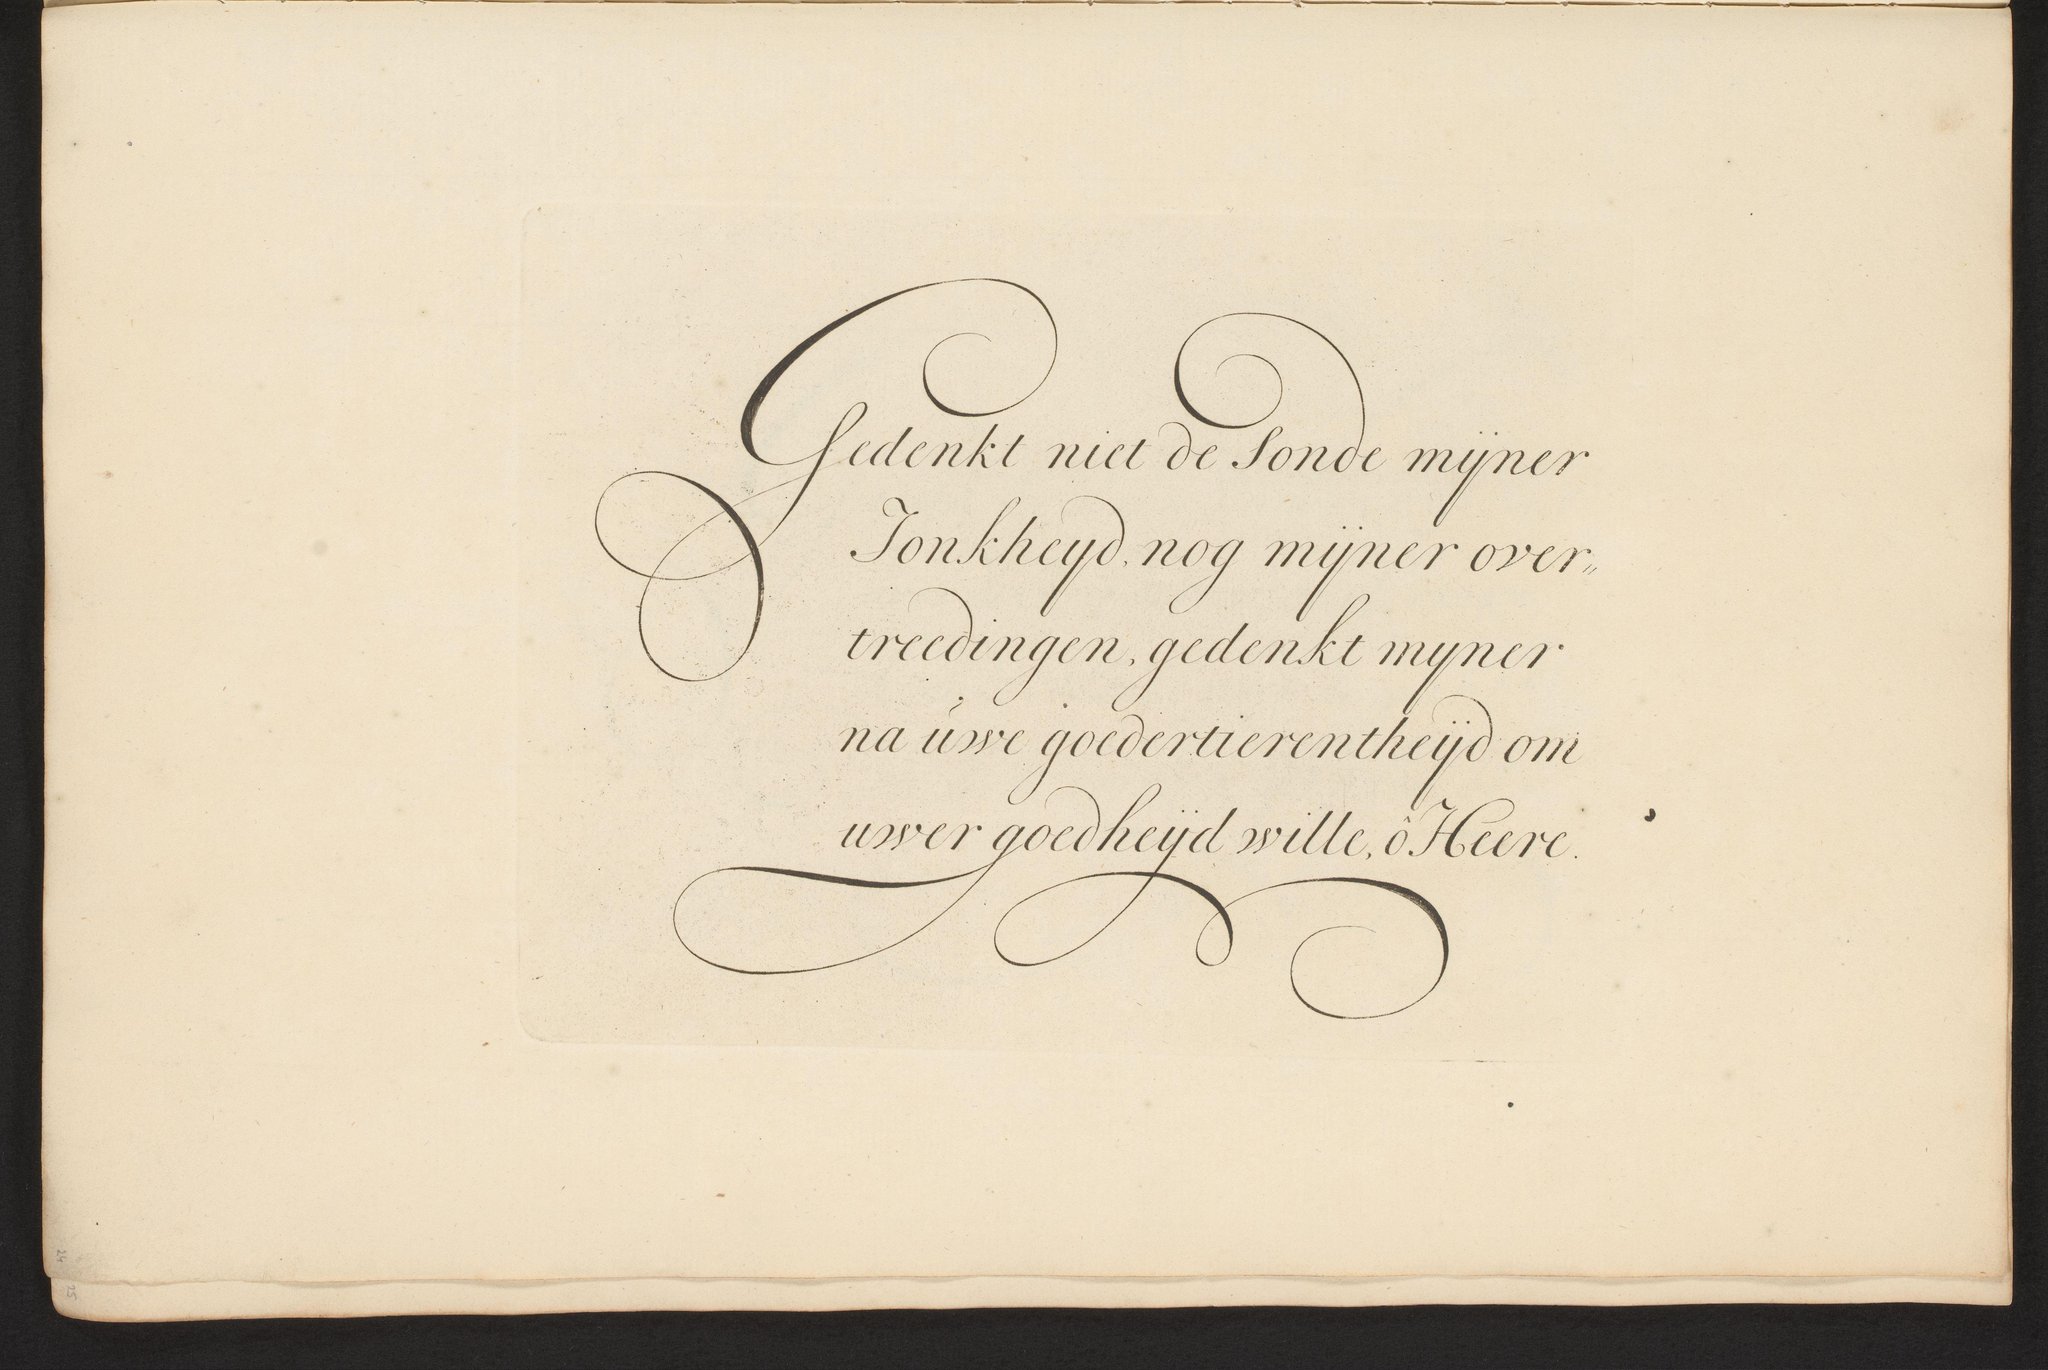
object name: album leaf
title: Schrijfvoorbeeld: Gedenkt niet de Sonde mijner Jonkheyd (...)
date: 1660-1751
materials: paper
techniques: engraving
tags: calligraphy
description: Schrijfvoorbeeld met vijf regels tekst in het Nederlands: Gedenkt niet de Sonde mijner Jonkheyd ... De prent maakt deel uit van een album